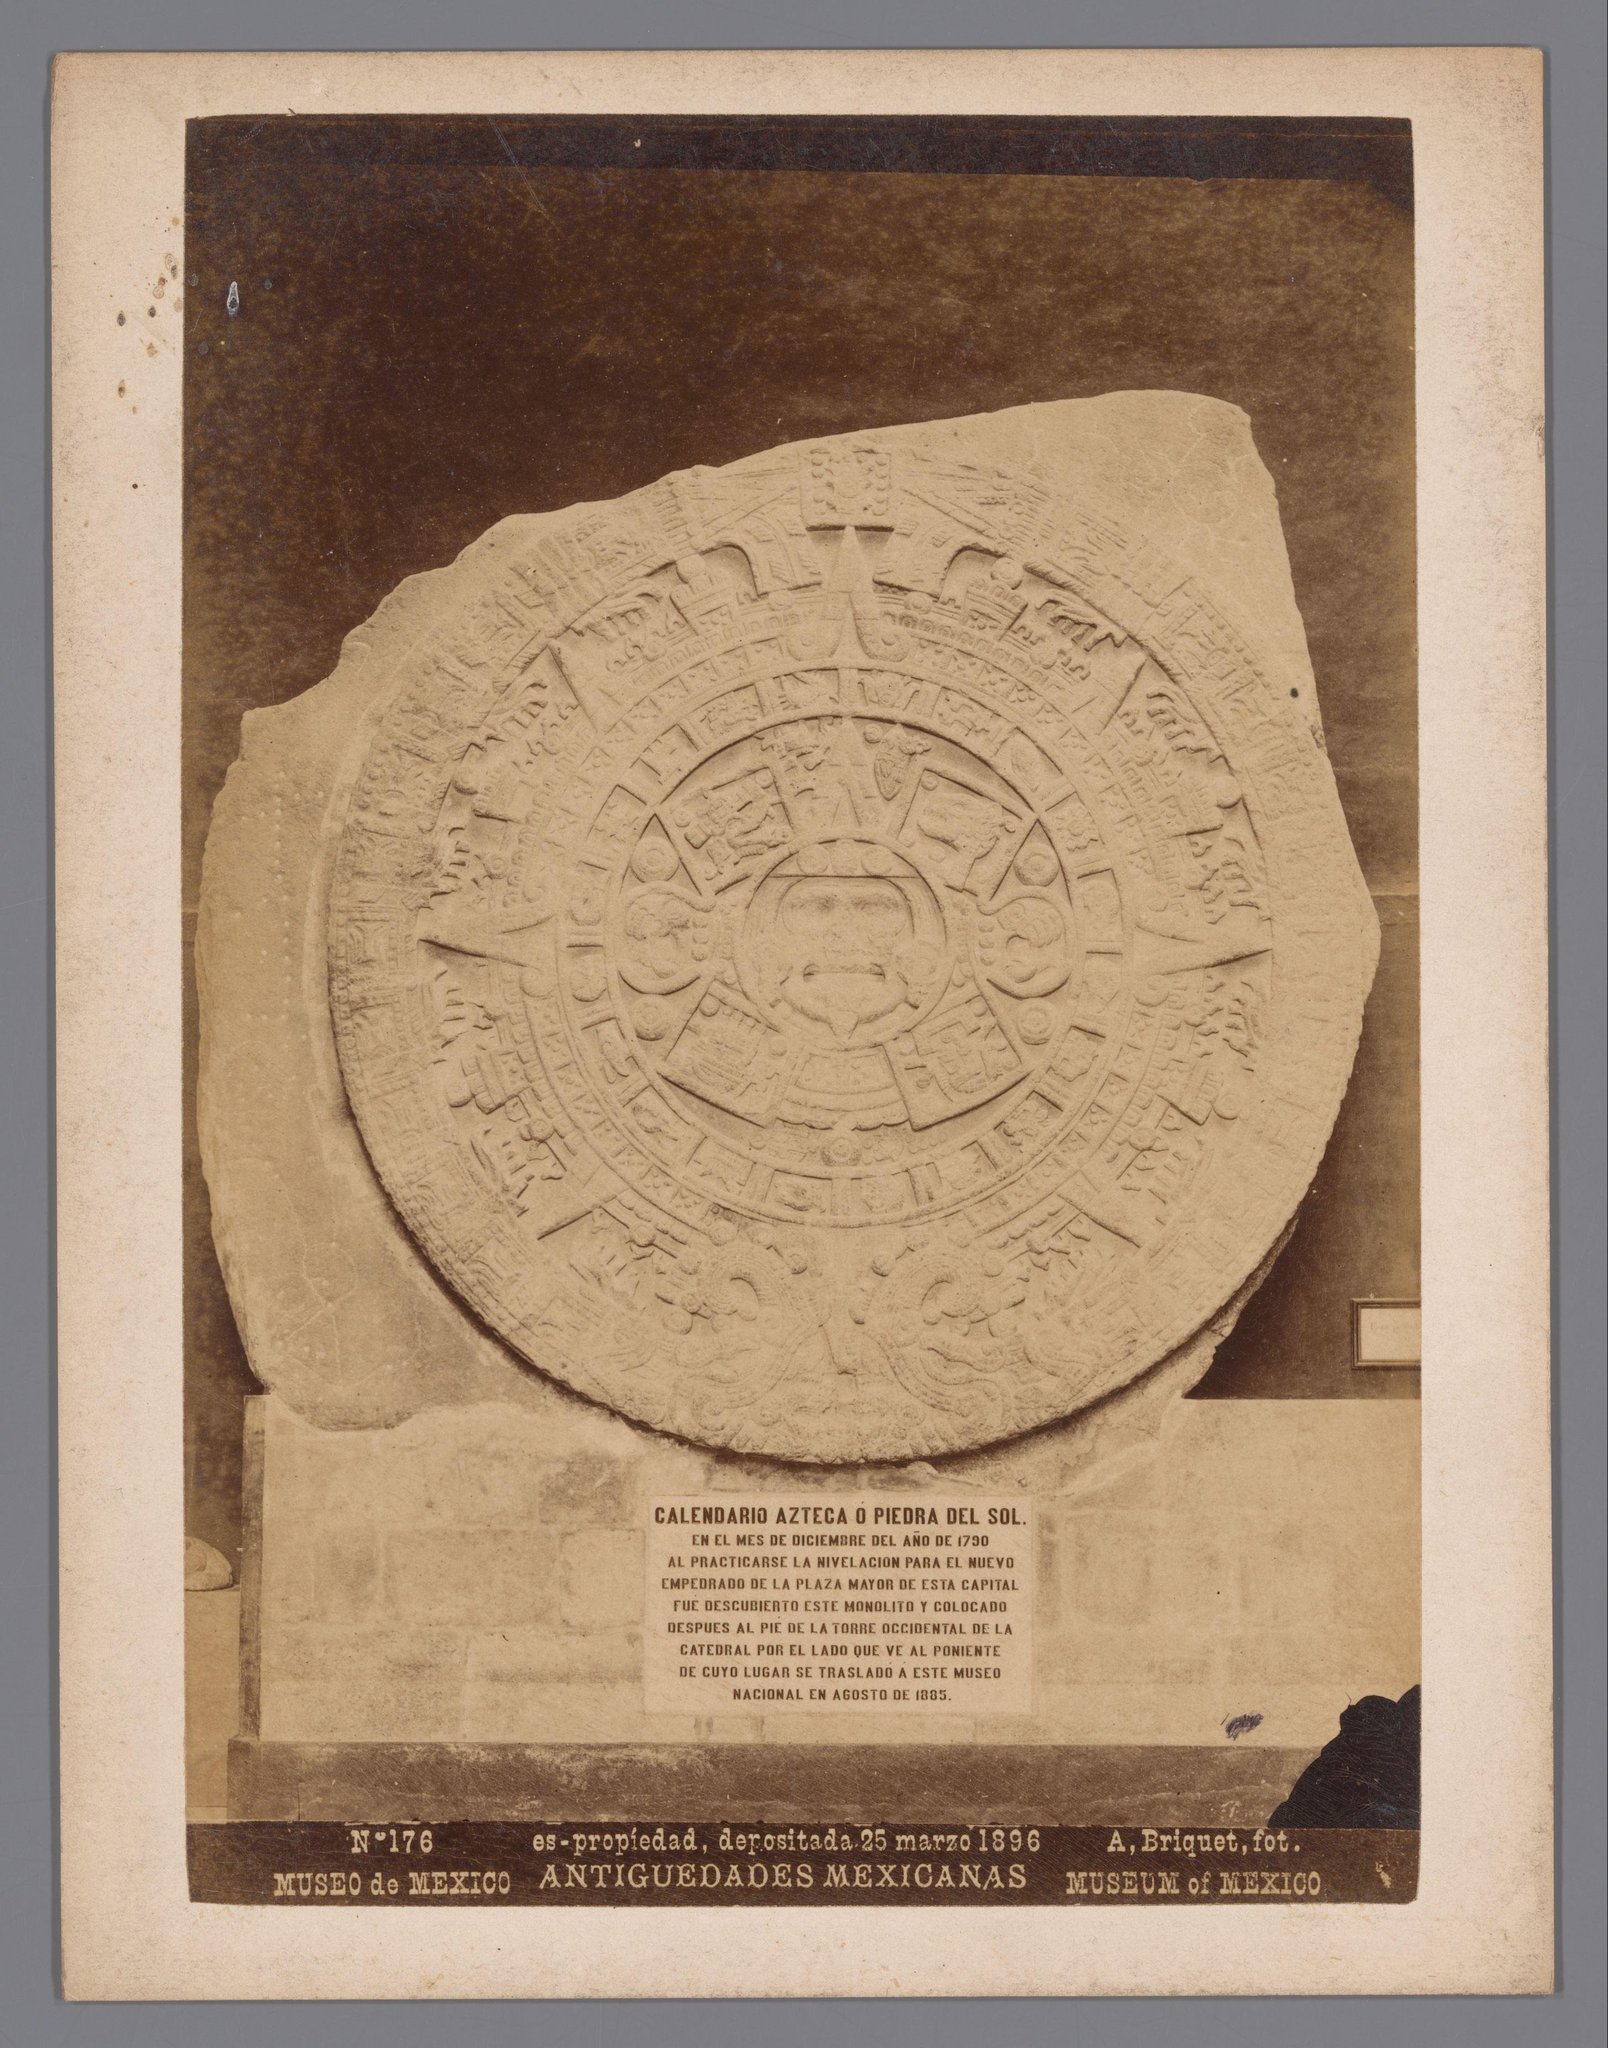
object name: photograph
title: Piedra del Sol in het archeologisch museum in Mexico-Stad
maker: abel briquet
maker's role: fotograaf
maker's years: 1833-1926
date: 1896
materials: cardboard, paper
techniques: albumen print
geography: mexico city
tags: calendar, almanac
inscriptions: copyright notice: ‘es-propriedad, depositada 25 marzo 1896’, number: ‘N. 176’